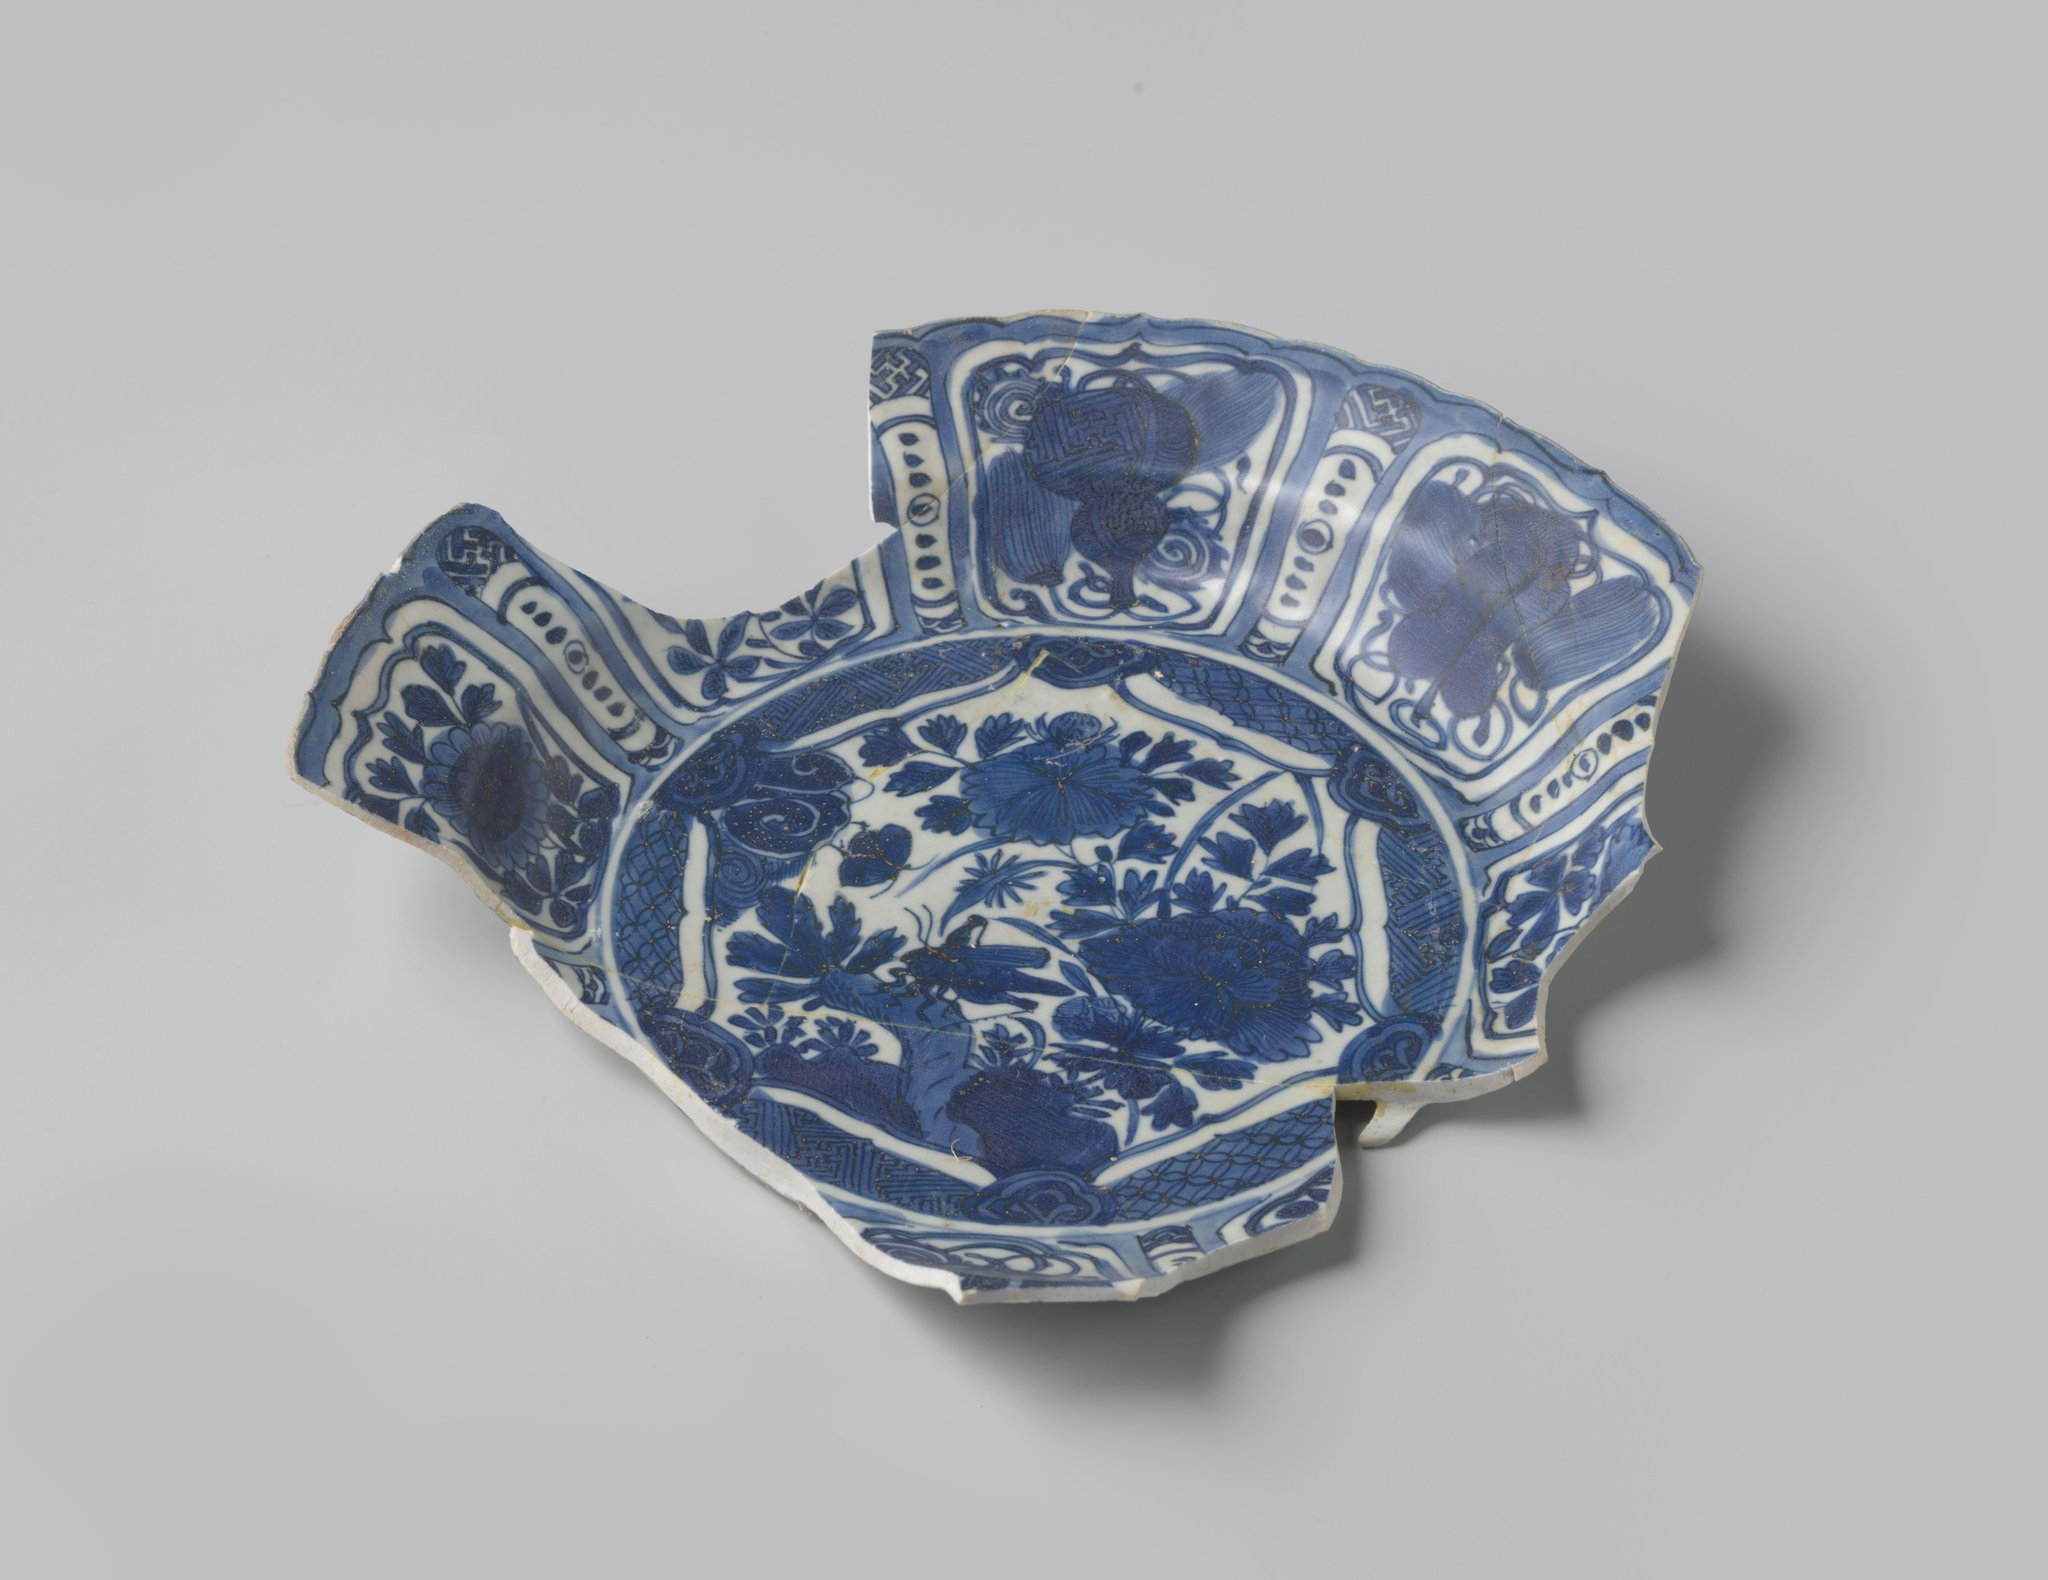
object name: plate dish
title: Fragmenten bord uit V.O.C.-schip de 'Witte Leeuw'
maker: Anonymous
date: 1613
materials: bone china, porcelain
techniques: painted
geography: jingdezhen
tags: verenigde oostindische compagnie, sint-helena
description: A plate with a flattened rim. A scalloped medallion filled with alternating diaper patterns. and linking rui heads. A central decoration of a grasshopper on a rock and a peony. Panels decorated with flowers and symbols.